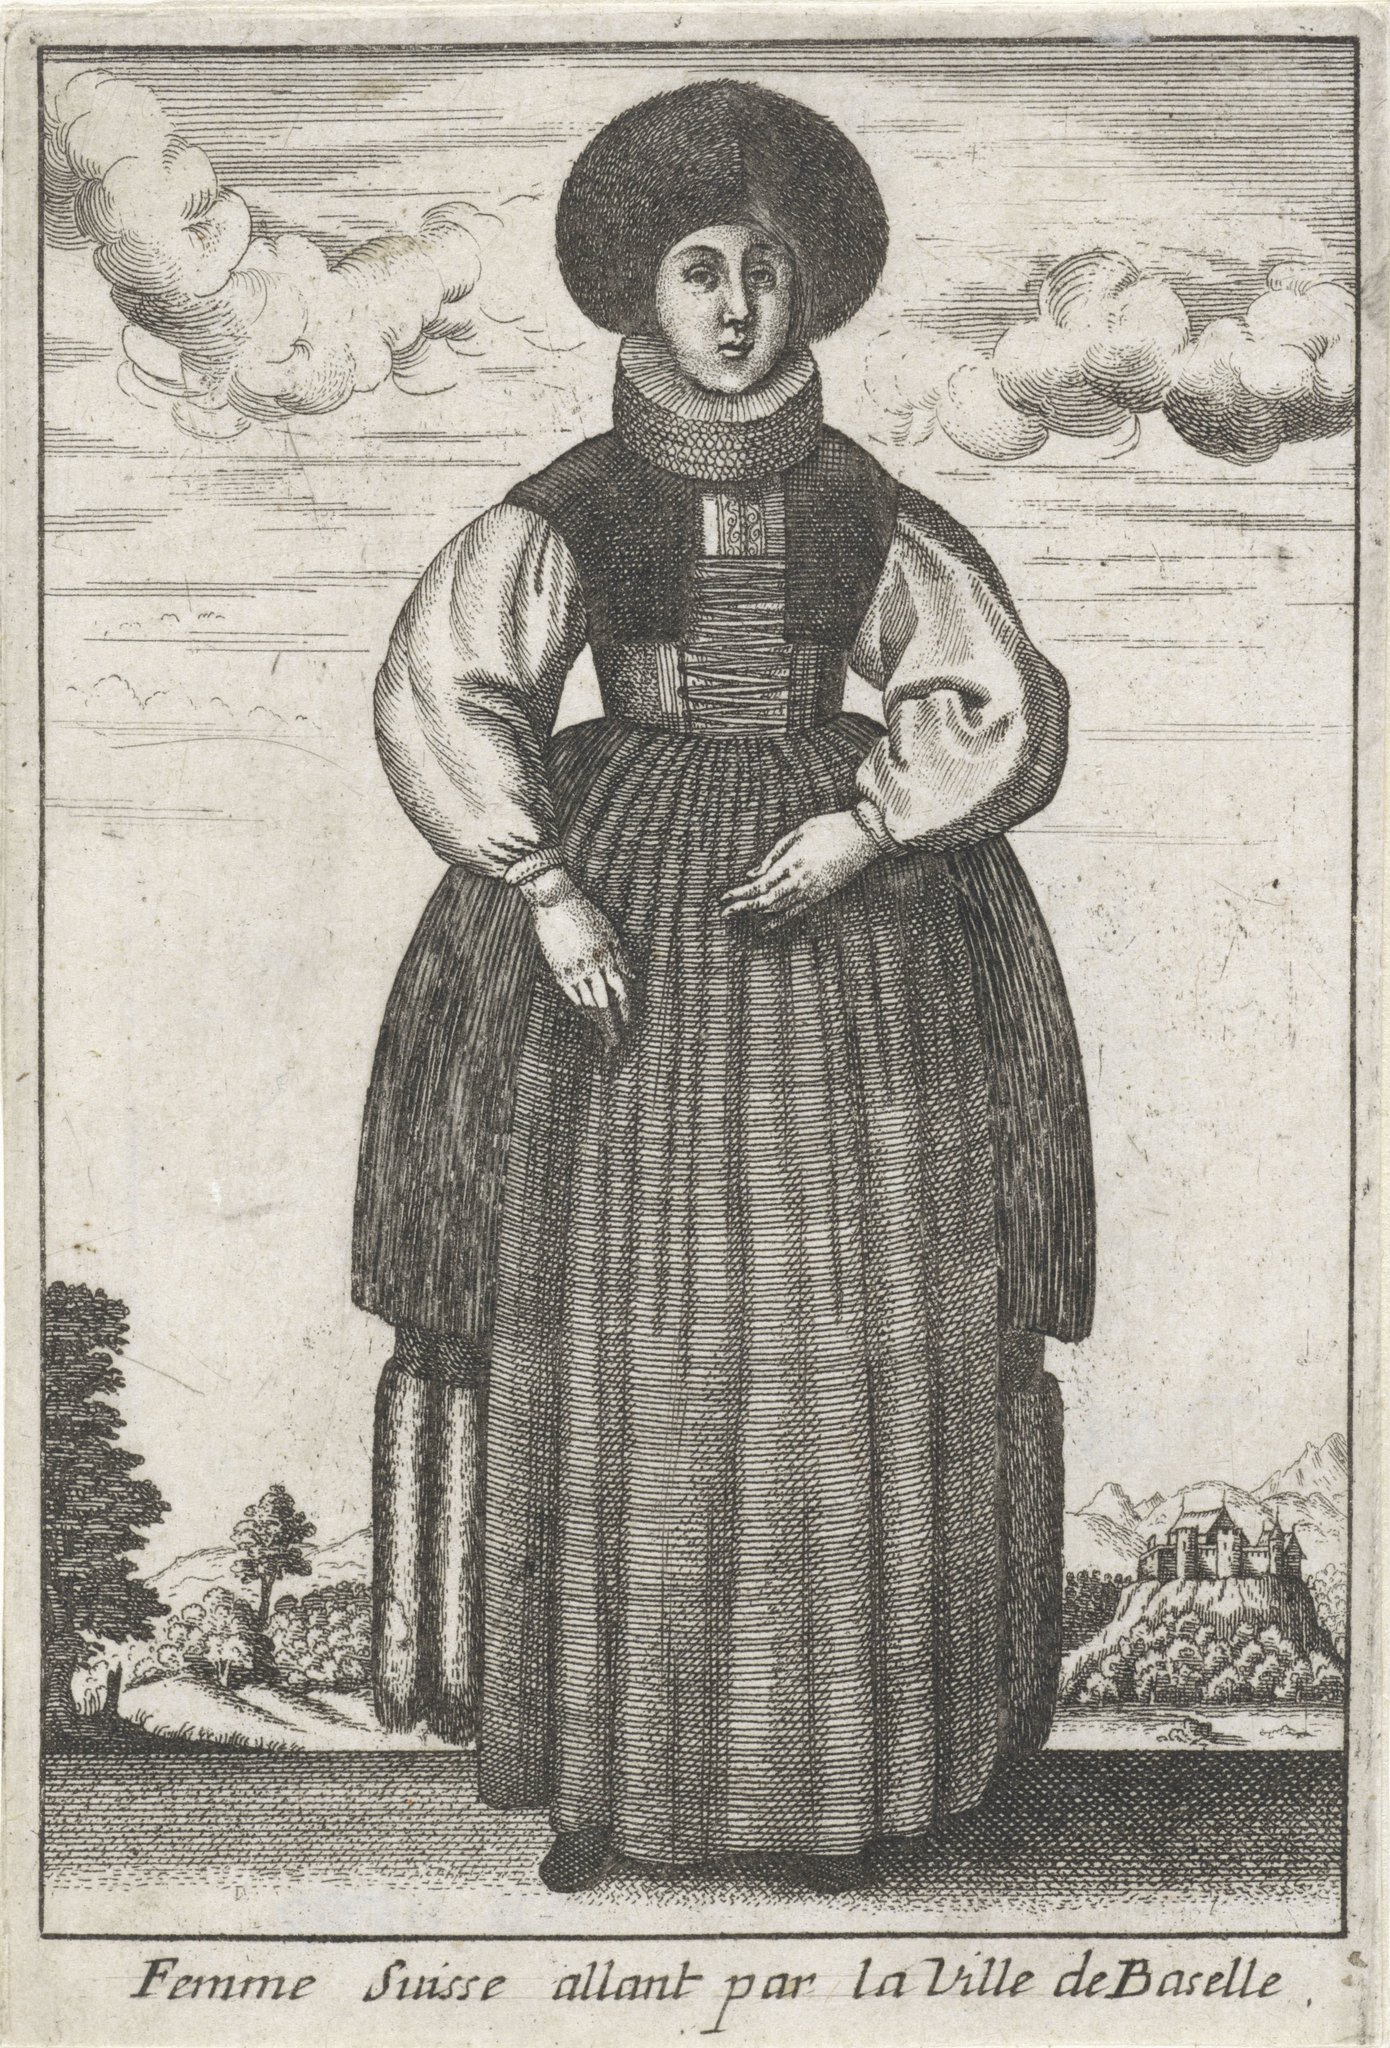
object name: costume print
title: Livre Curieux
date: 1662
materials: paper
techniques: etching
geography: paris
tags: bazel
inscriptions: collector's mark: Lugt 240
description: Kopie naar prent die deel uitmaakt van de 50-delige serie met Europese klederdrachten, getiteld "Aula Veneris".. De prent maakt deel uit van de 28-delige serie (excl. titelprent) met voorstellingen van vrouwen in verschillende klederdrachten, getiteld "Livre curieux contenant la naifue representations des habits des femmes des diverses parties du Monde (...), 1662".